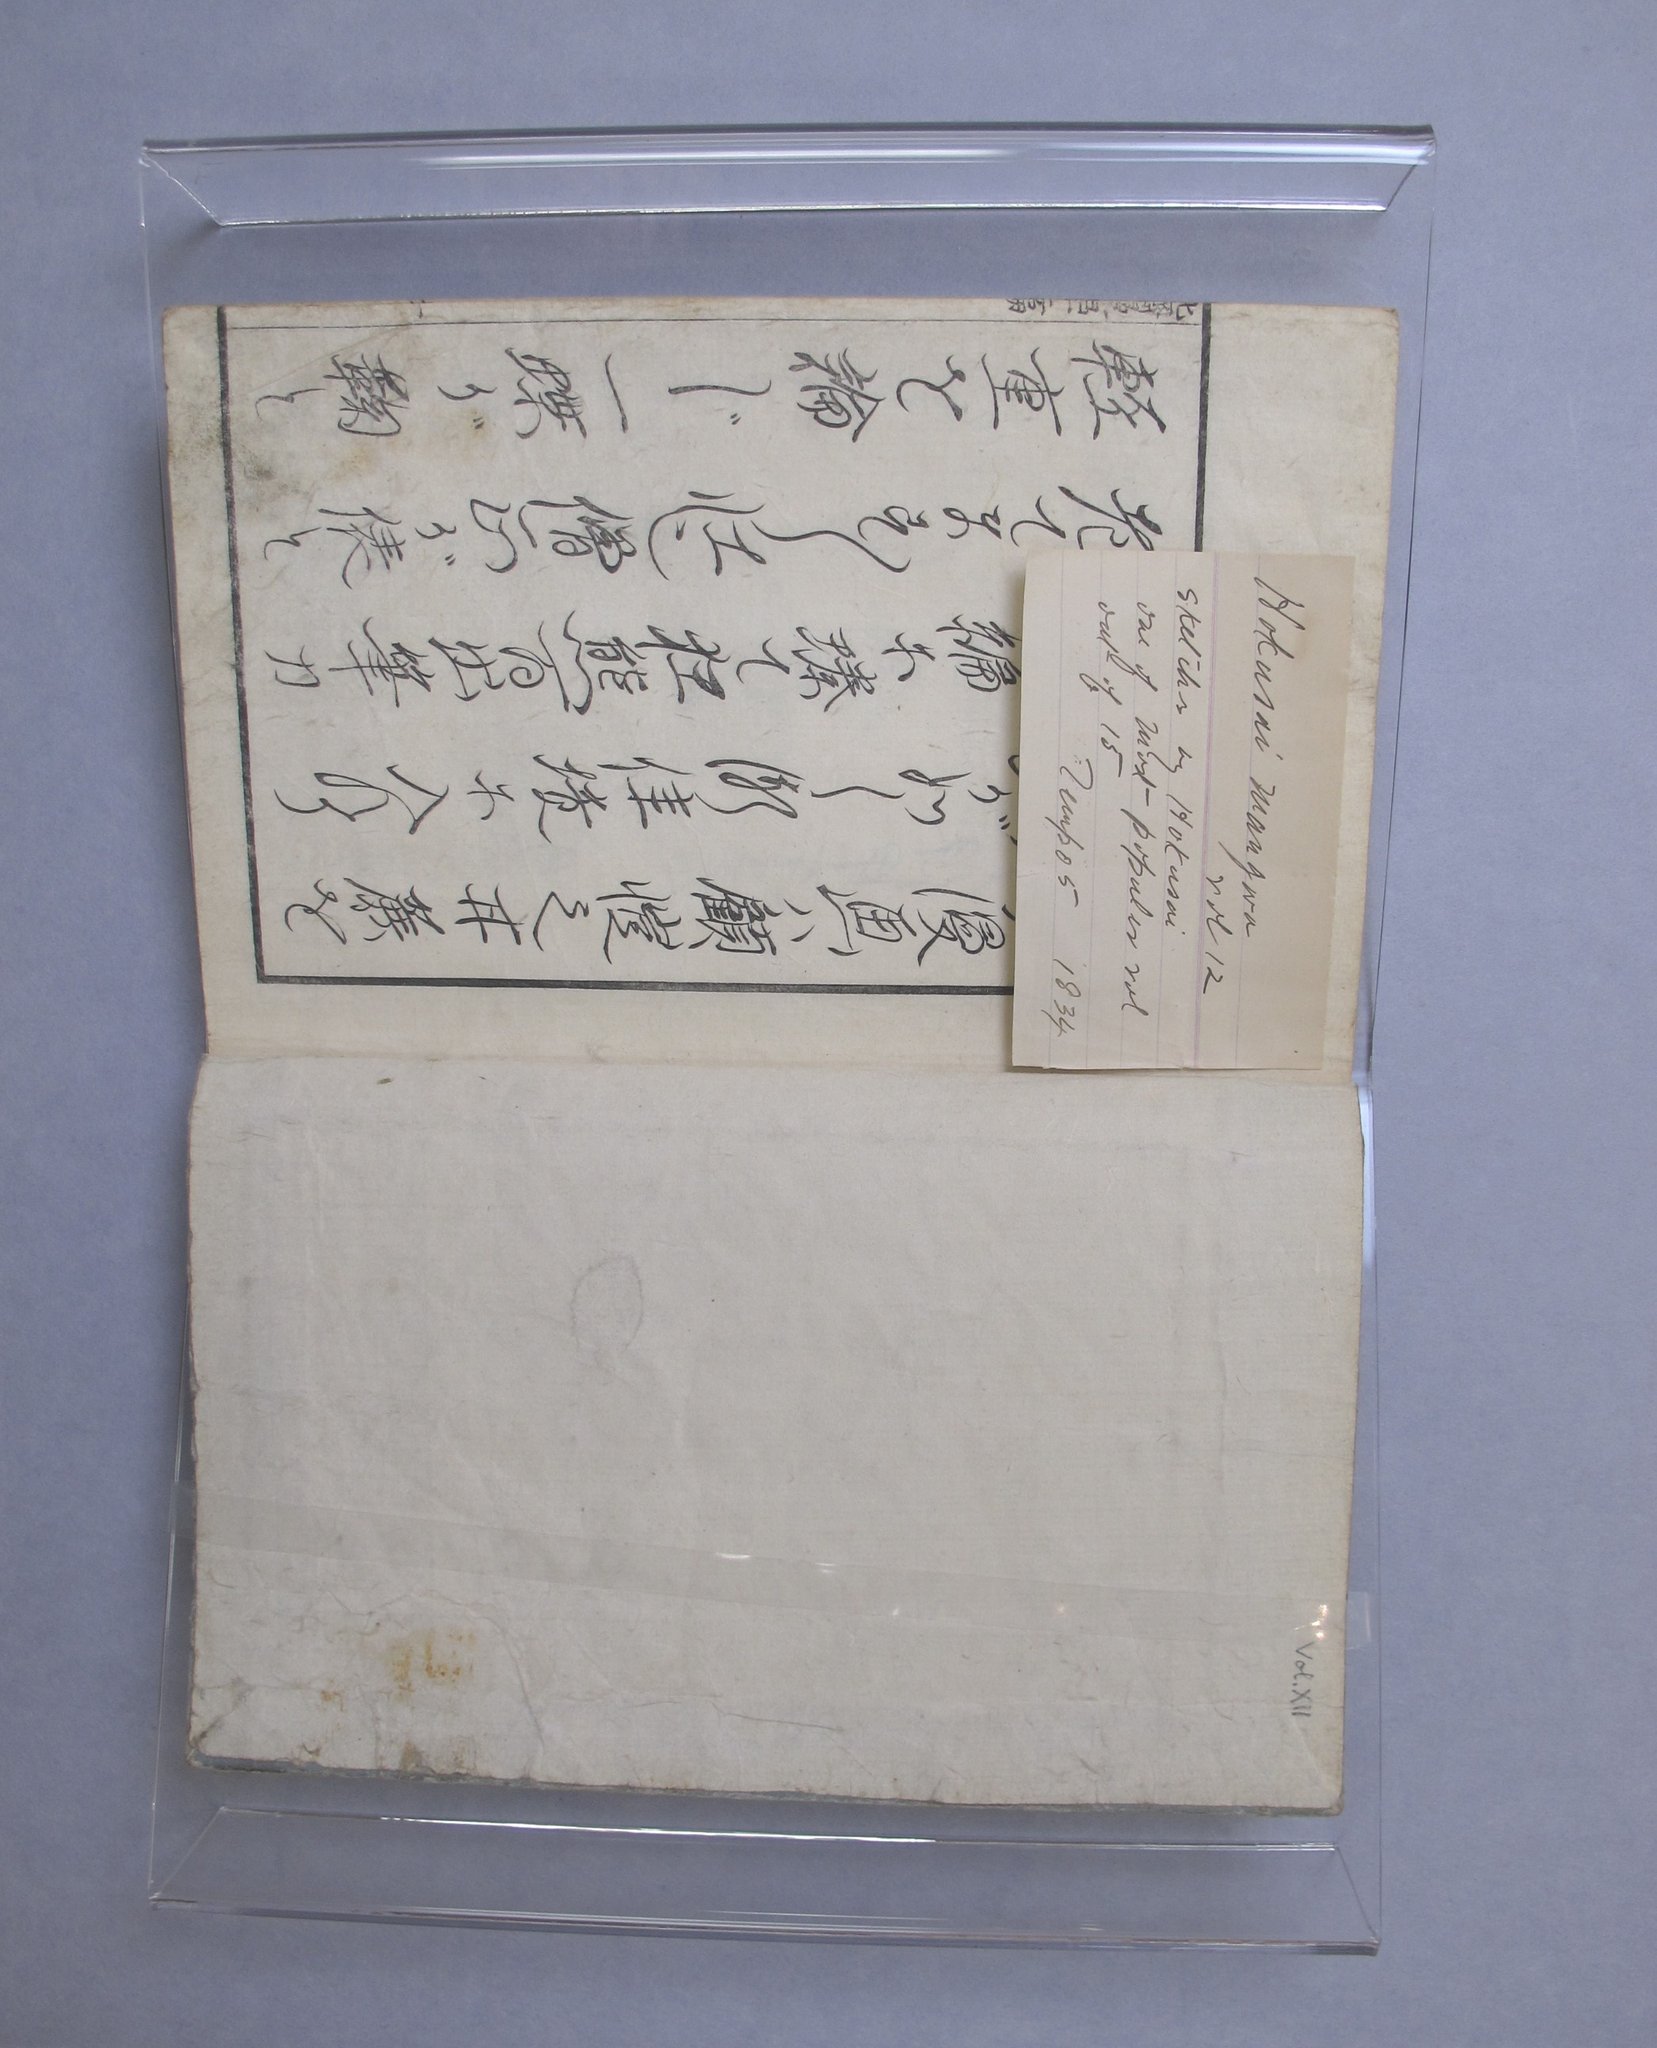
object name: illustrated book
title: Random Sketches by Hokusai, Volume 12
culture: japanese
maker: katsushika hokusai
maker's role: artist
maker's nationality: japanese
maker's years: 1760-1849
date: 1834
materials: ink, paper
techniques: woodblock print